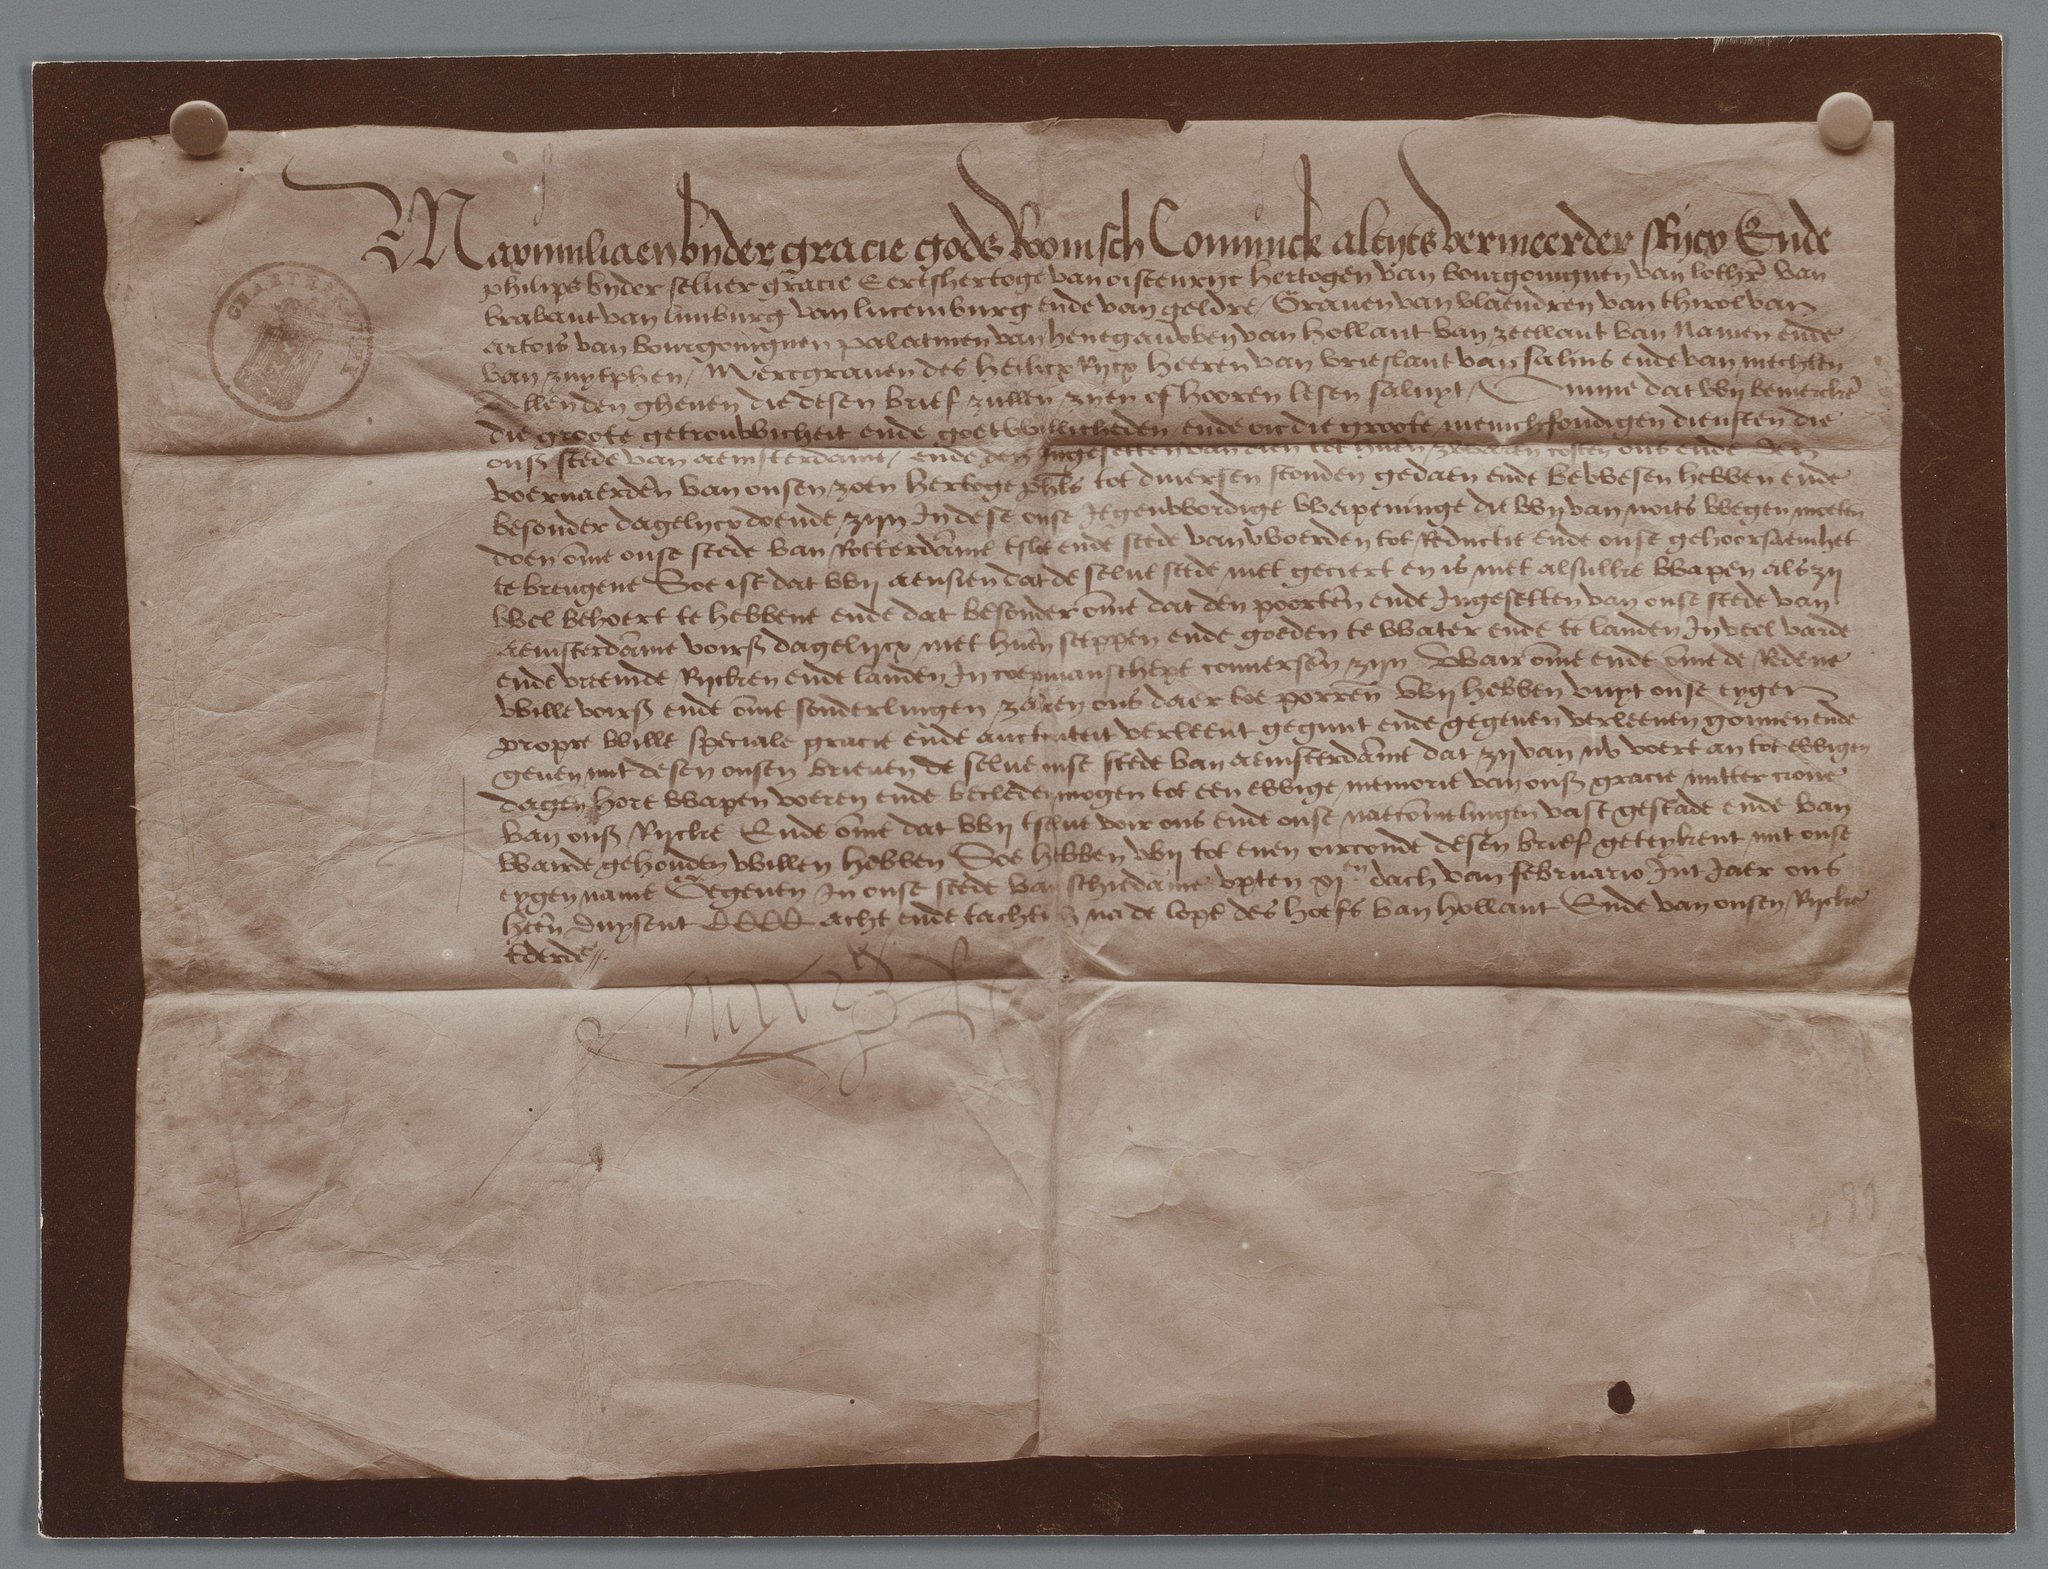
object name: photograph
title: Fotoreproductie van handgeschreven document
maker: Anonymous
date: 1880-1920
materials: paper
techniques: collodion silver print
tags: handwriting, written text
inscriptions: number: ‘26’